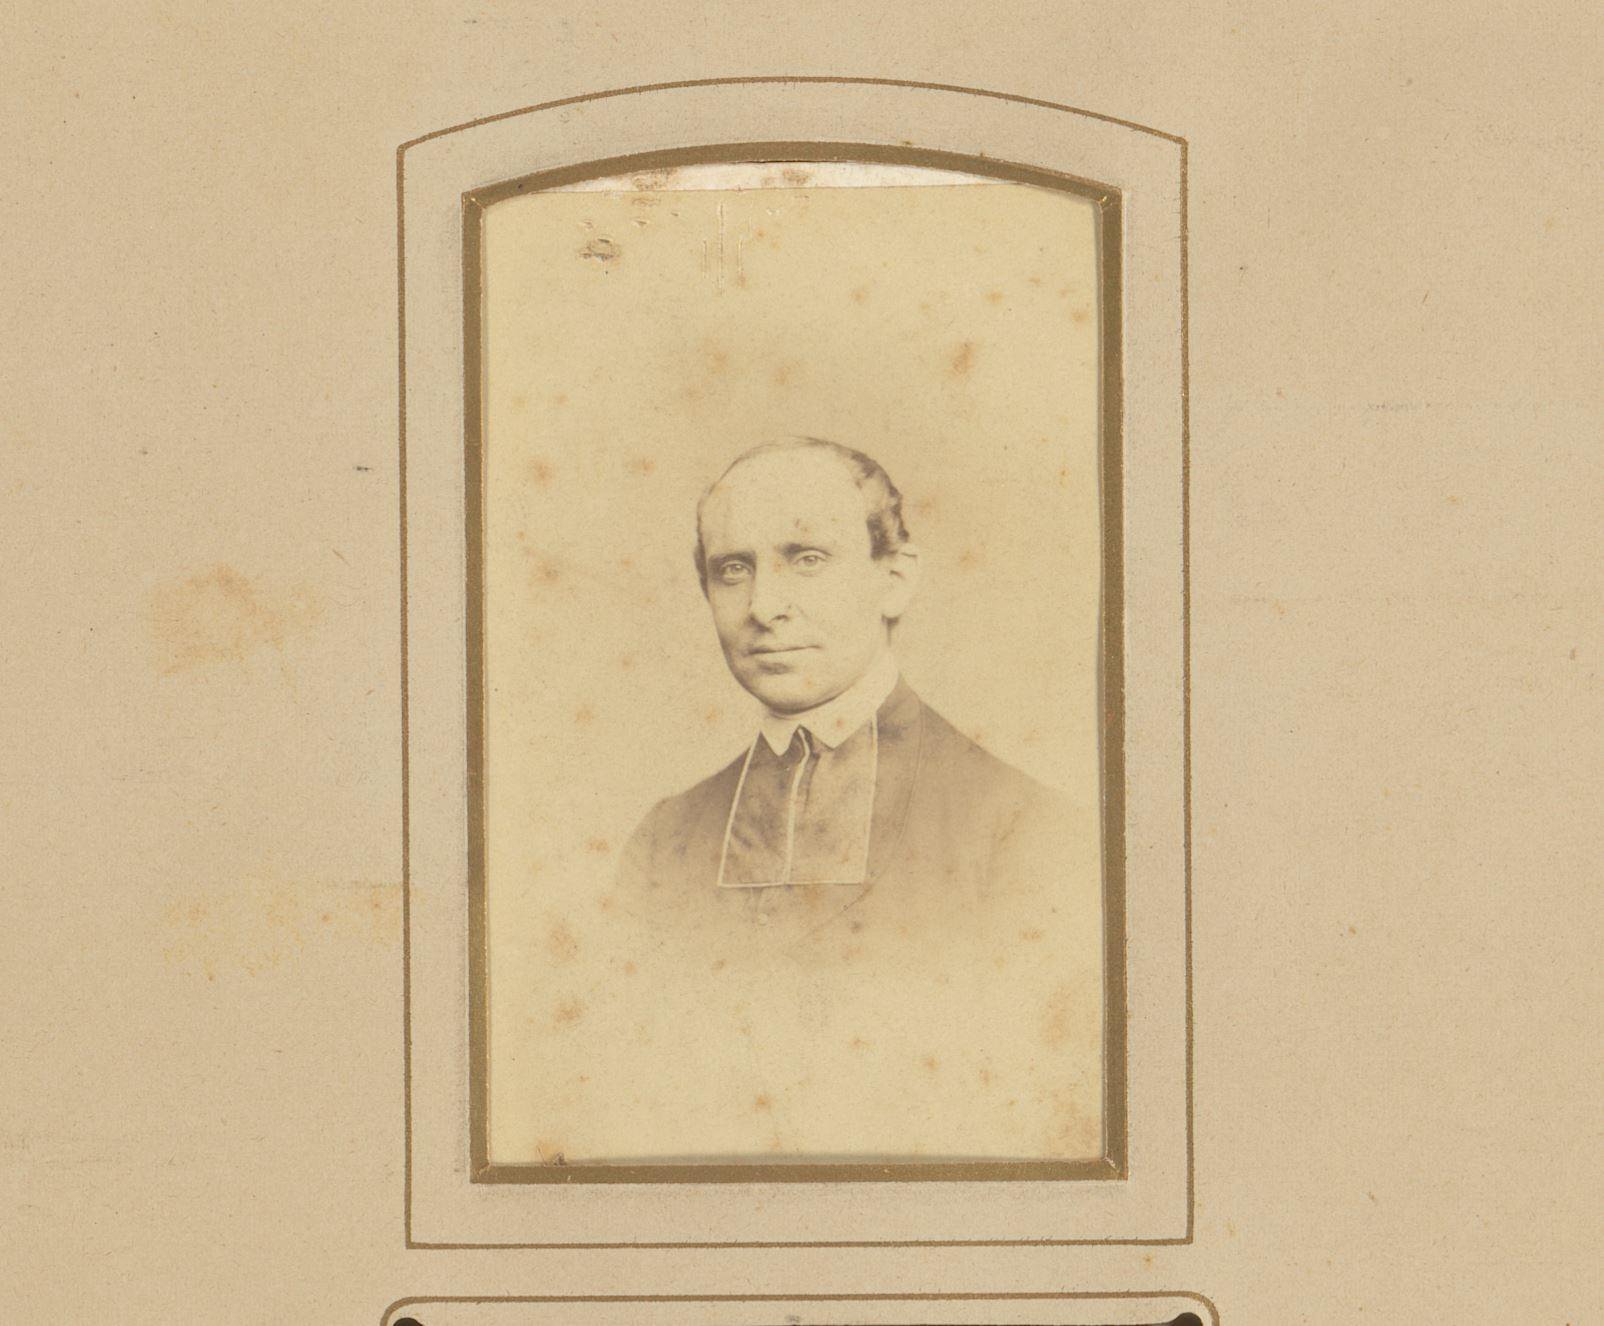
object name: photograph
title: Portret van een geestelijke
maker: henri blanckart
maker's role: fotograaf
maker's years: 1833-1894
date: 1865-1870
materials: cardboard, photographic support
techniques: albumen print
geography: saint-trond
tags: historical persons, organization, functionaries and dignitaries in roman catholic church; clergy in general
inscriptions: annotation: ‘H Blanckart phot./ à St Trond’